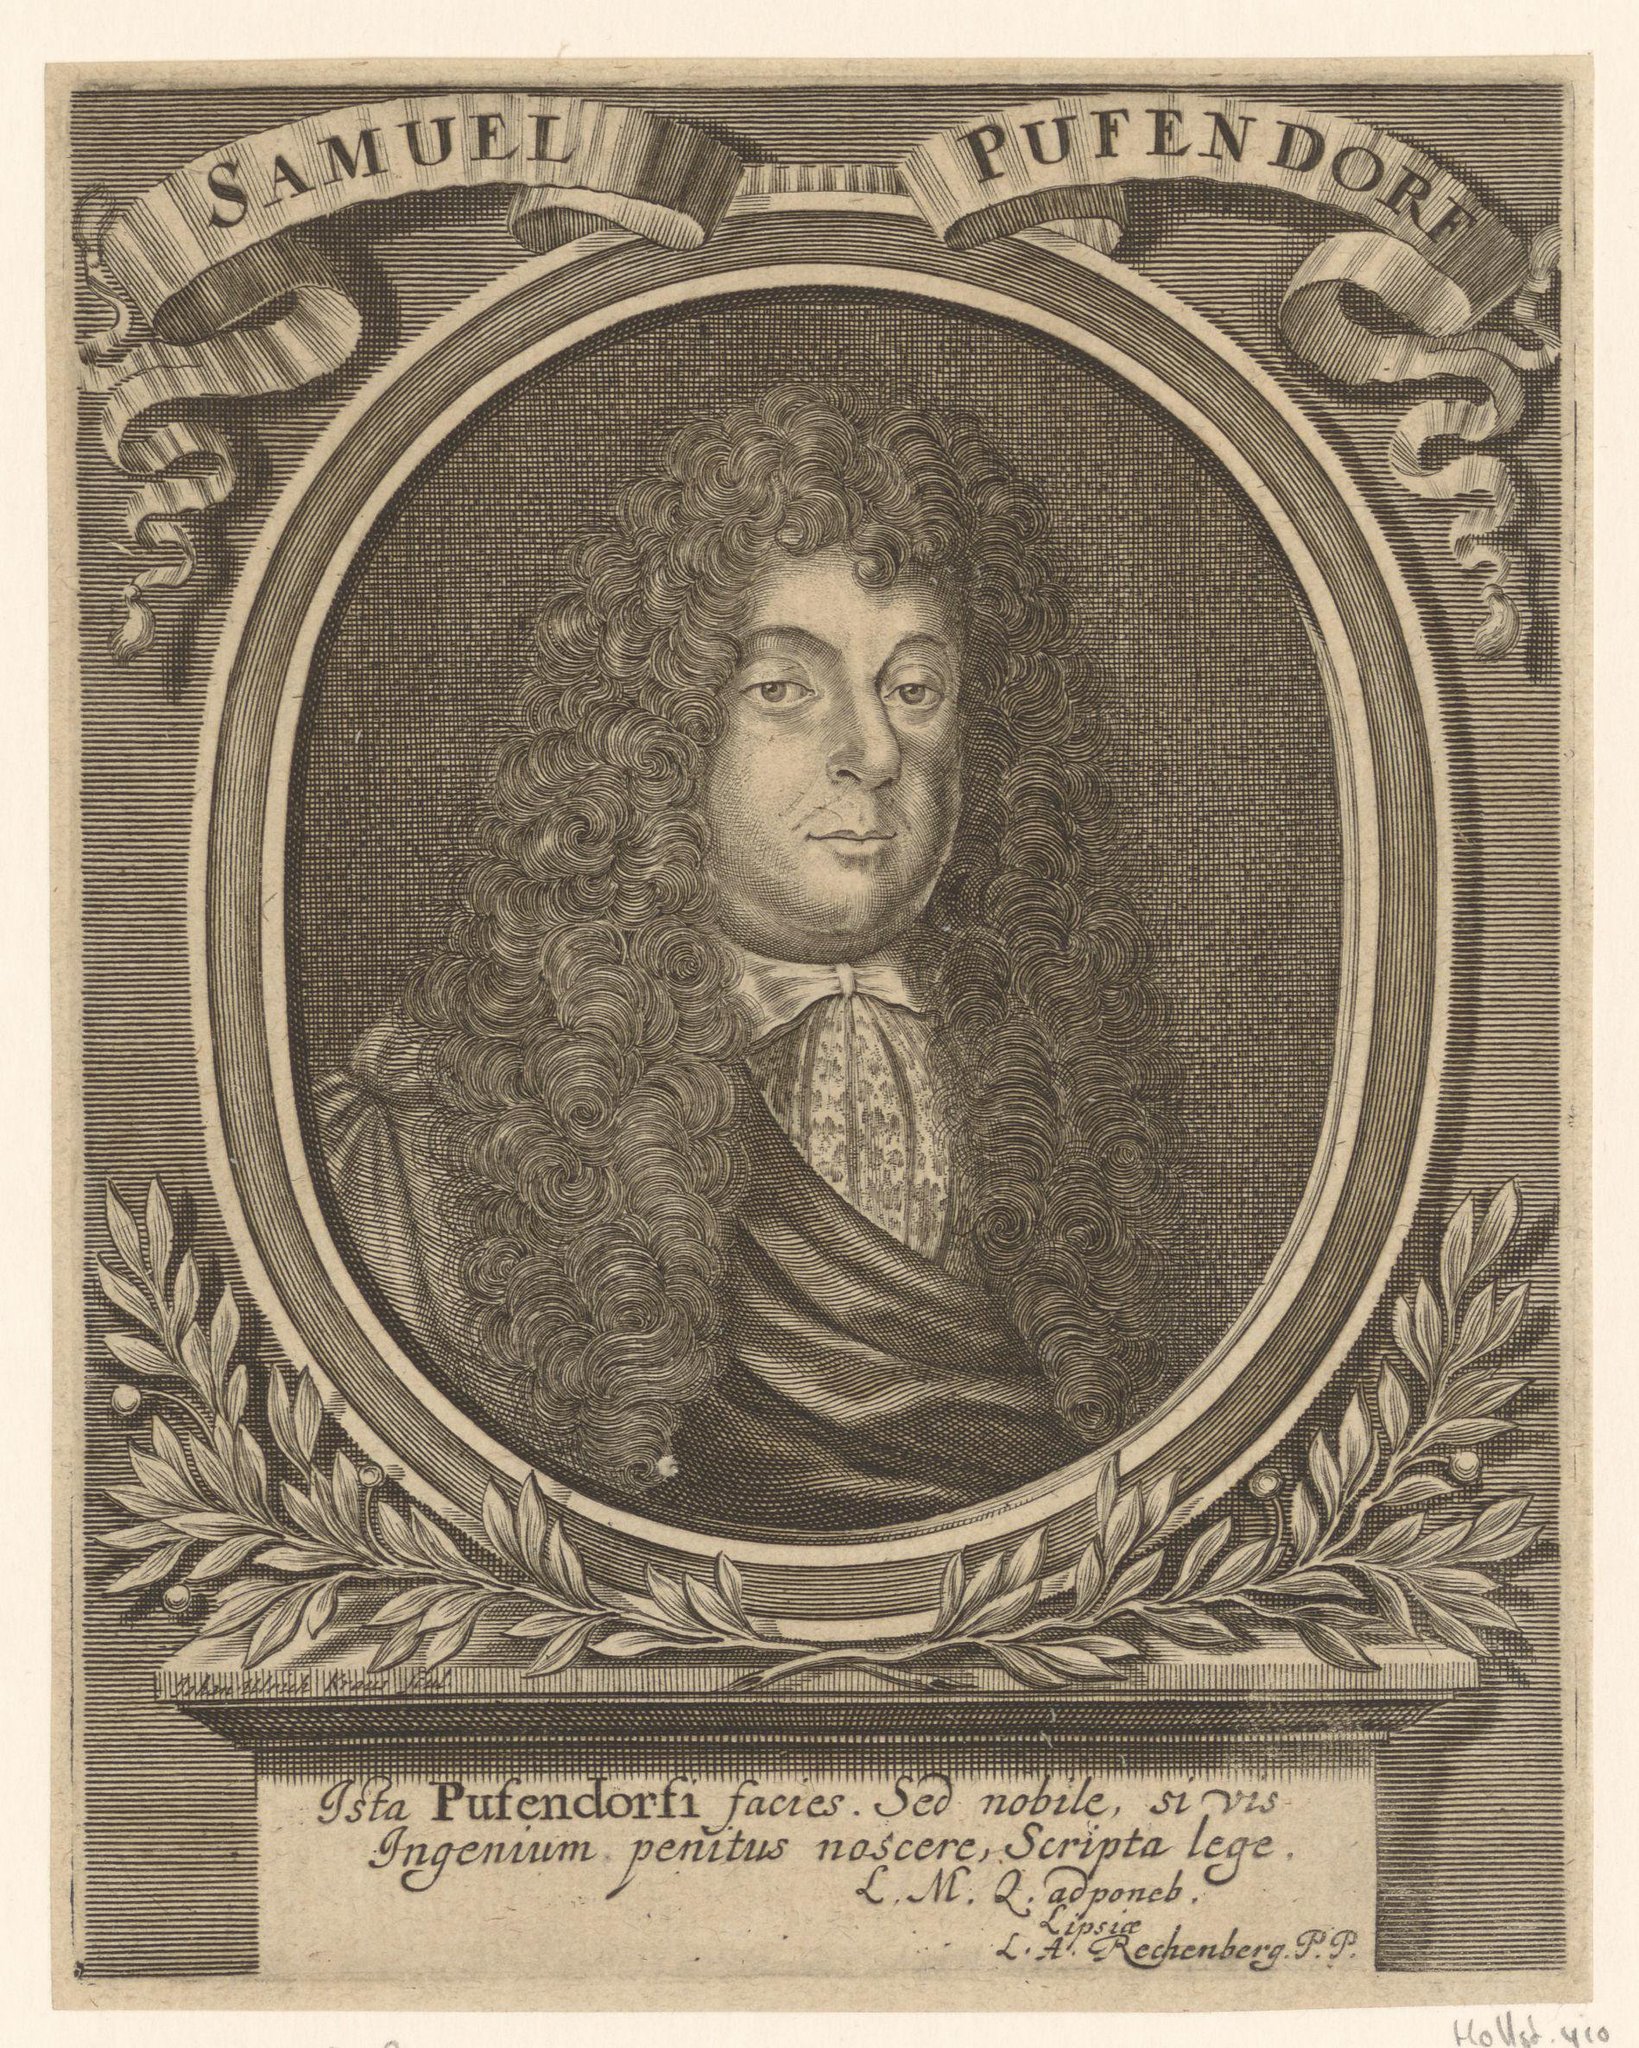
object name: print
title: Portret van Samuel von Pufendorf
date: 1665-1719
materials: paper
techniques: engraving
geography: leipzig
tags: history and archaeology (+ portrait of scholar, scientist), further education (+ portrait of teacher, professor), historical persons, scholar, philosopher (+ portrait of scholar, scientist)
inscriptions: collector's mark: Lugt 2228